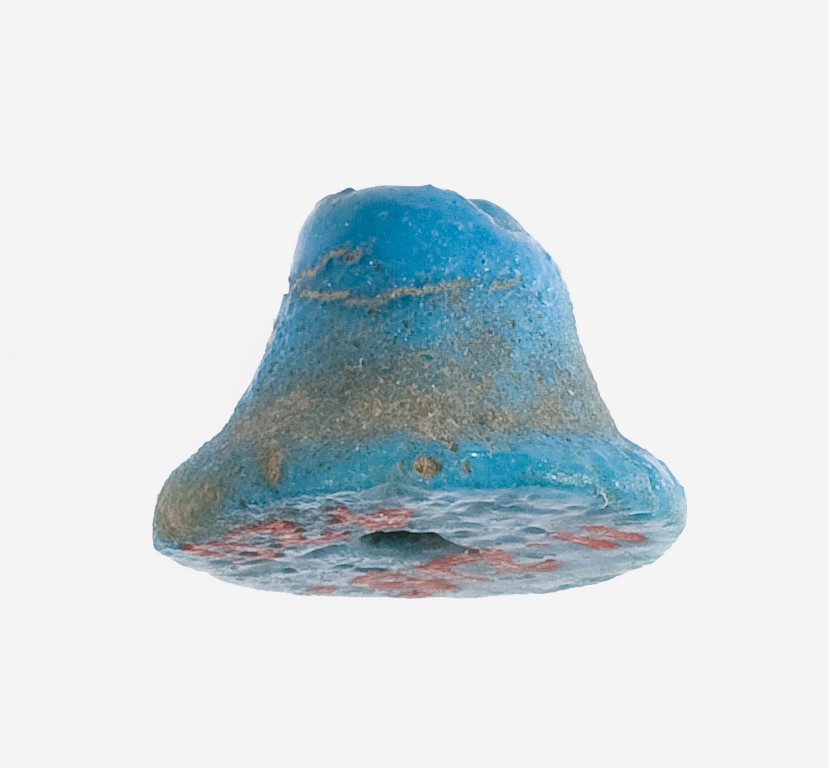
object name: pendant, umbel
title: Umbel Pendant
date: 1390-1352 BCE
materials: faience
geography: egypt